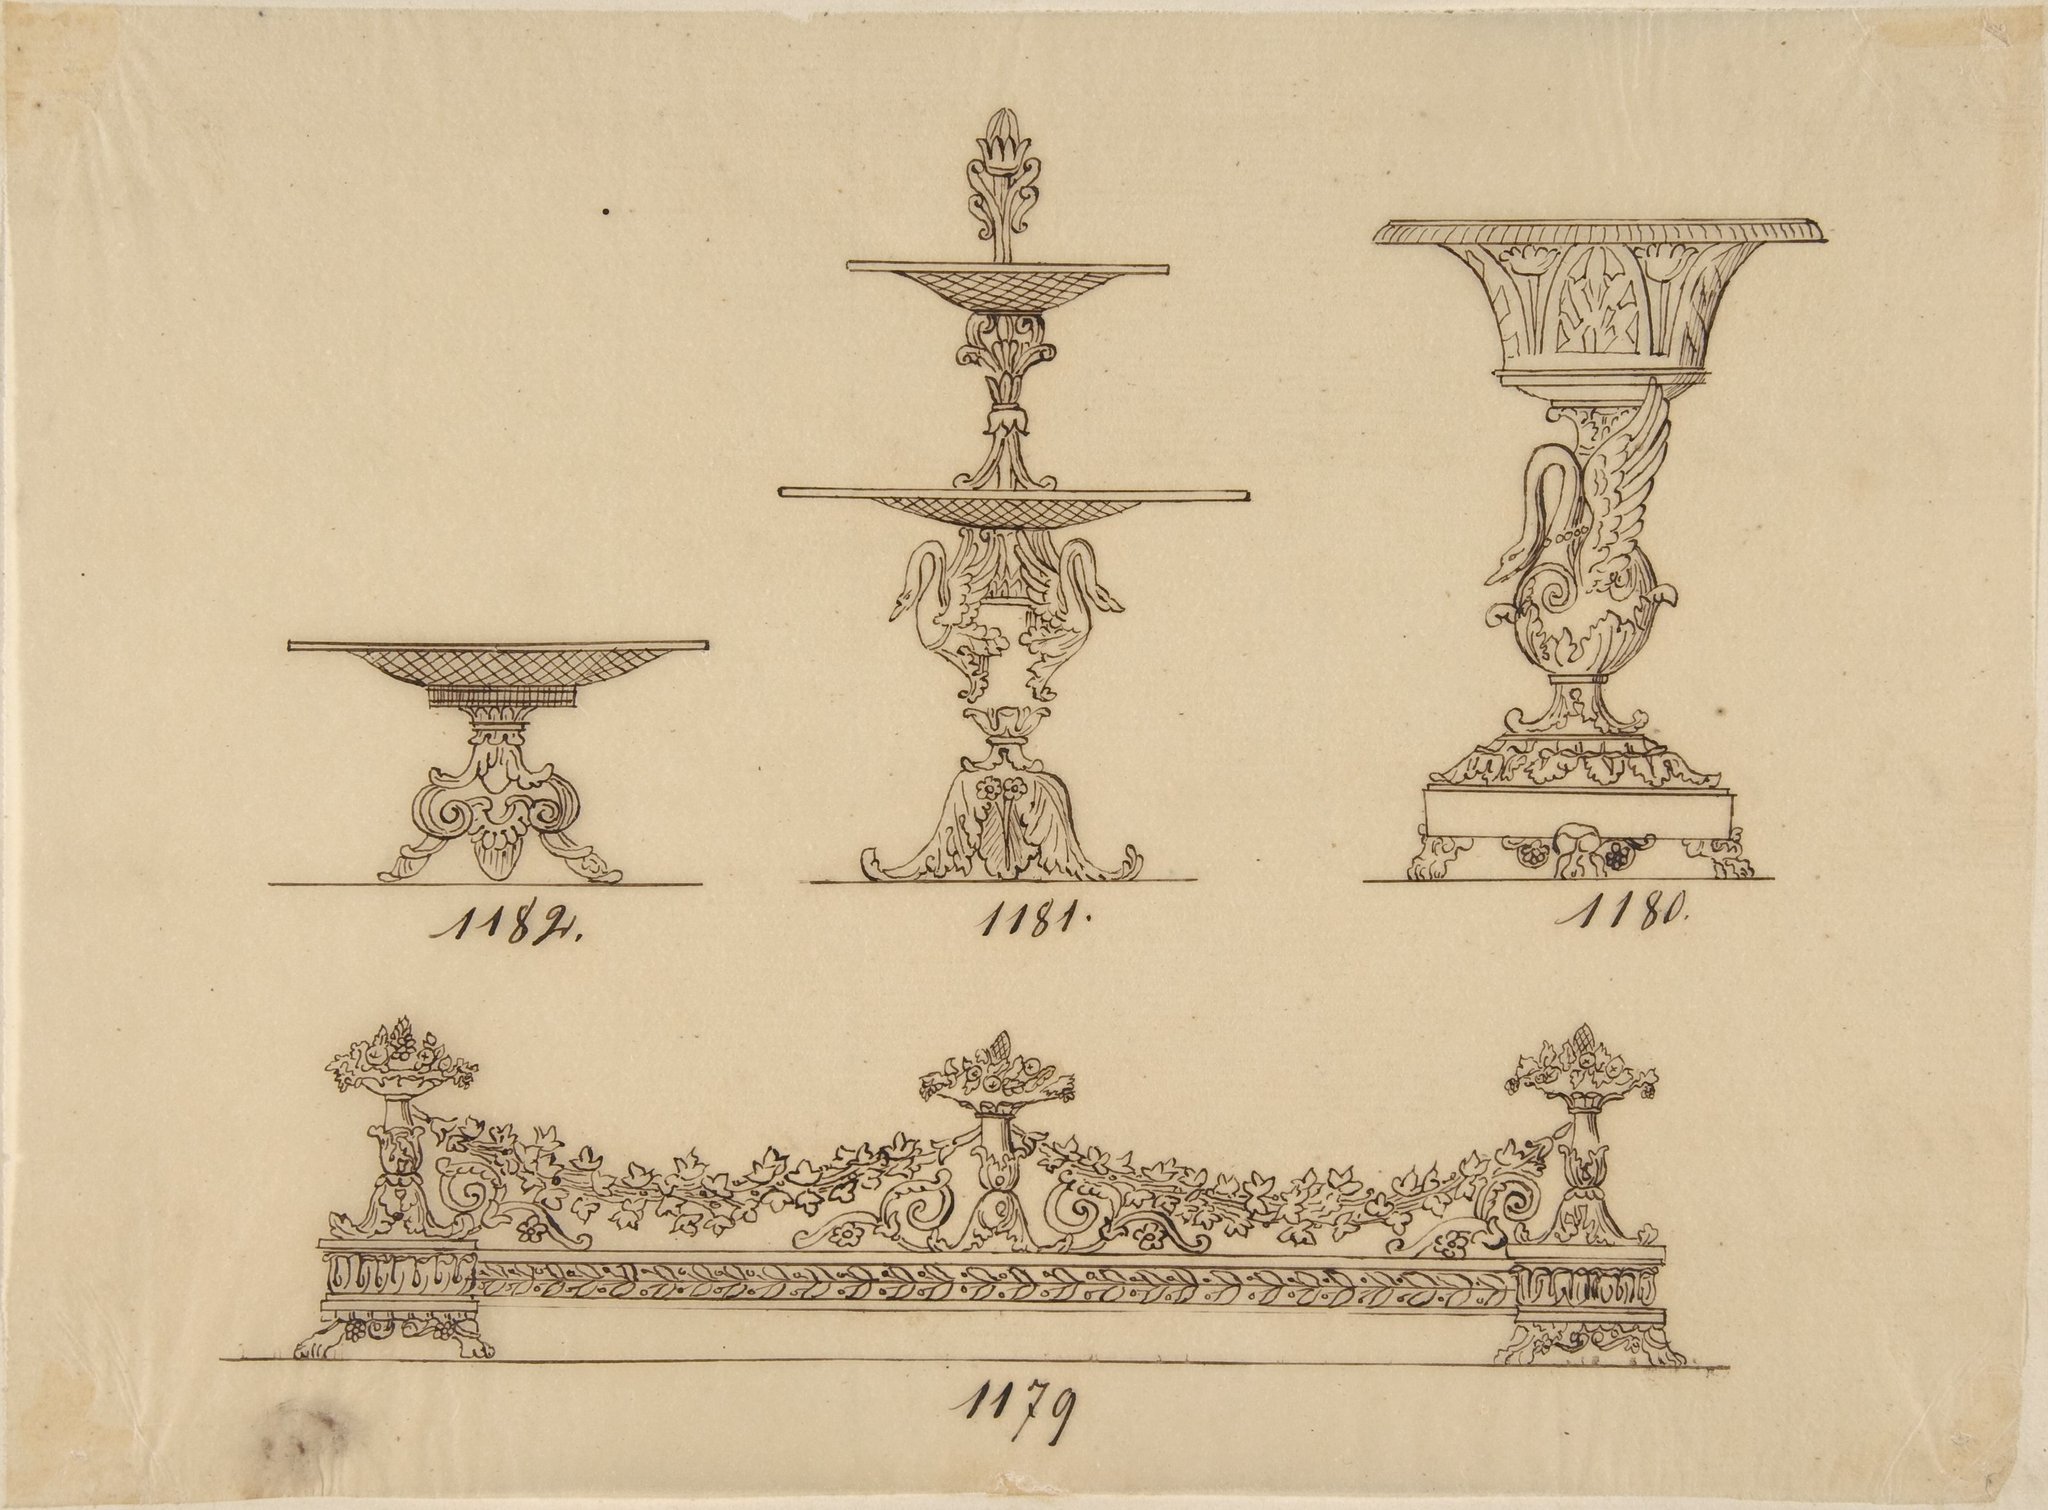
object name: drawing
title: Design for a Compote Dish, a Server and an Urn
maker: anonymous, french, 19th century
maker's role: artist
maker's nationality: french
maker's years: 1800-1900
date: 1801-1900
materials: ink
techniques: pen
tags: dishes,urns